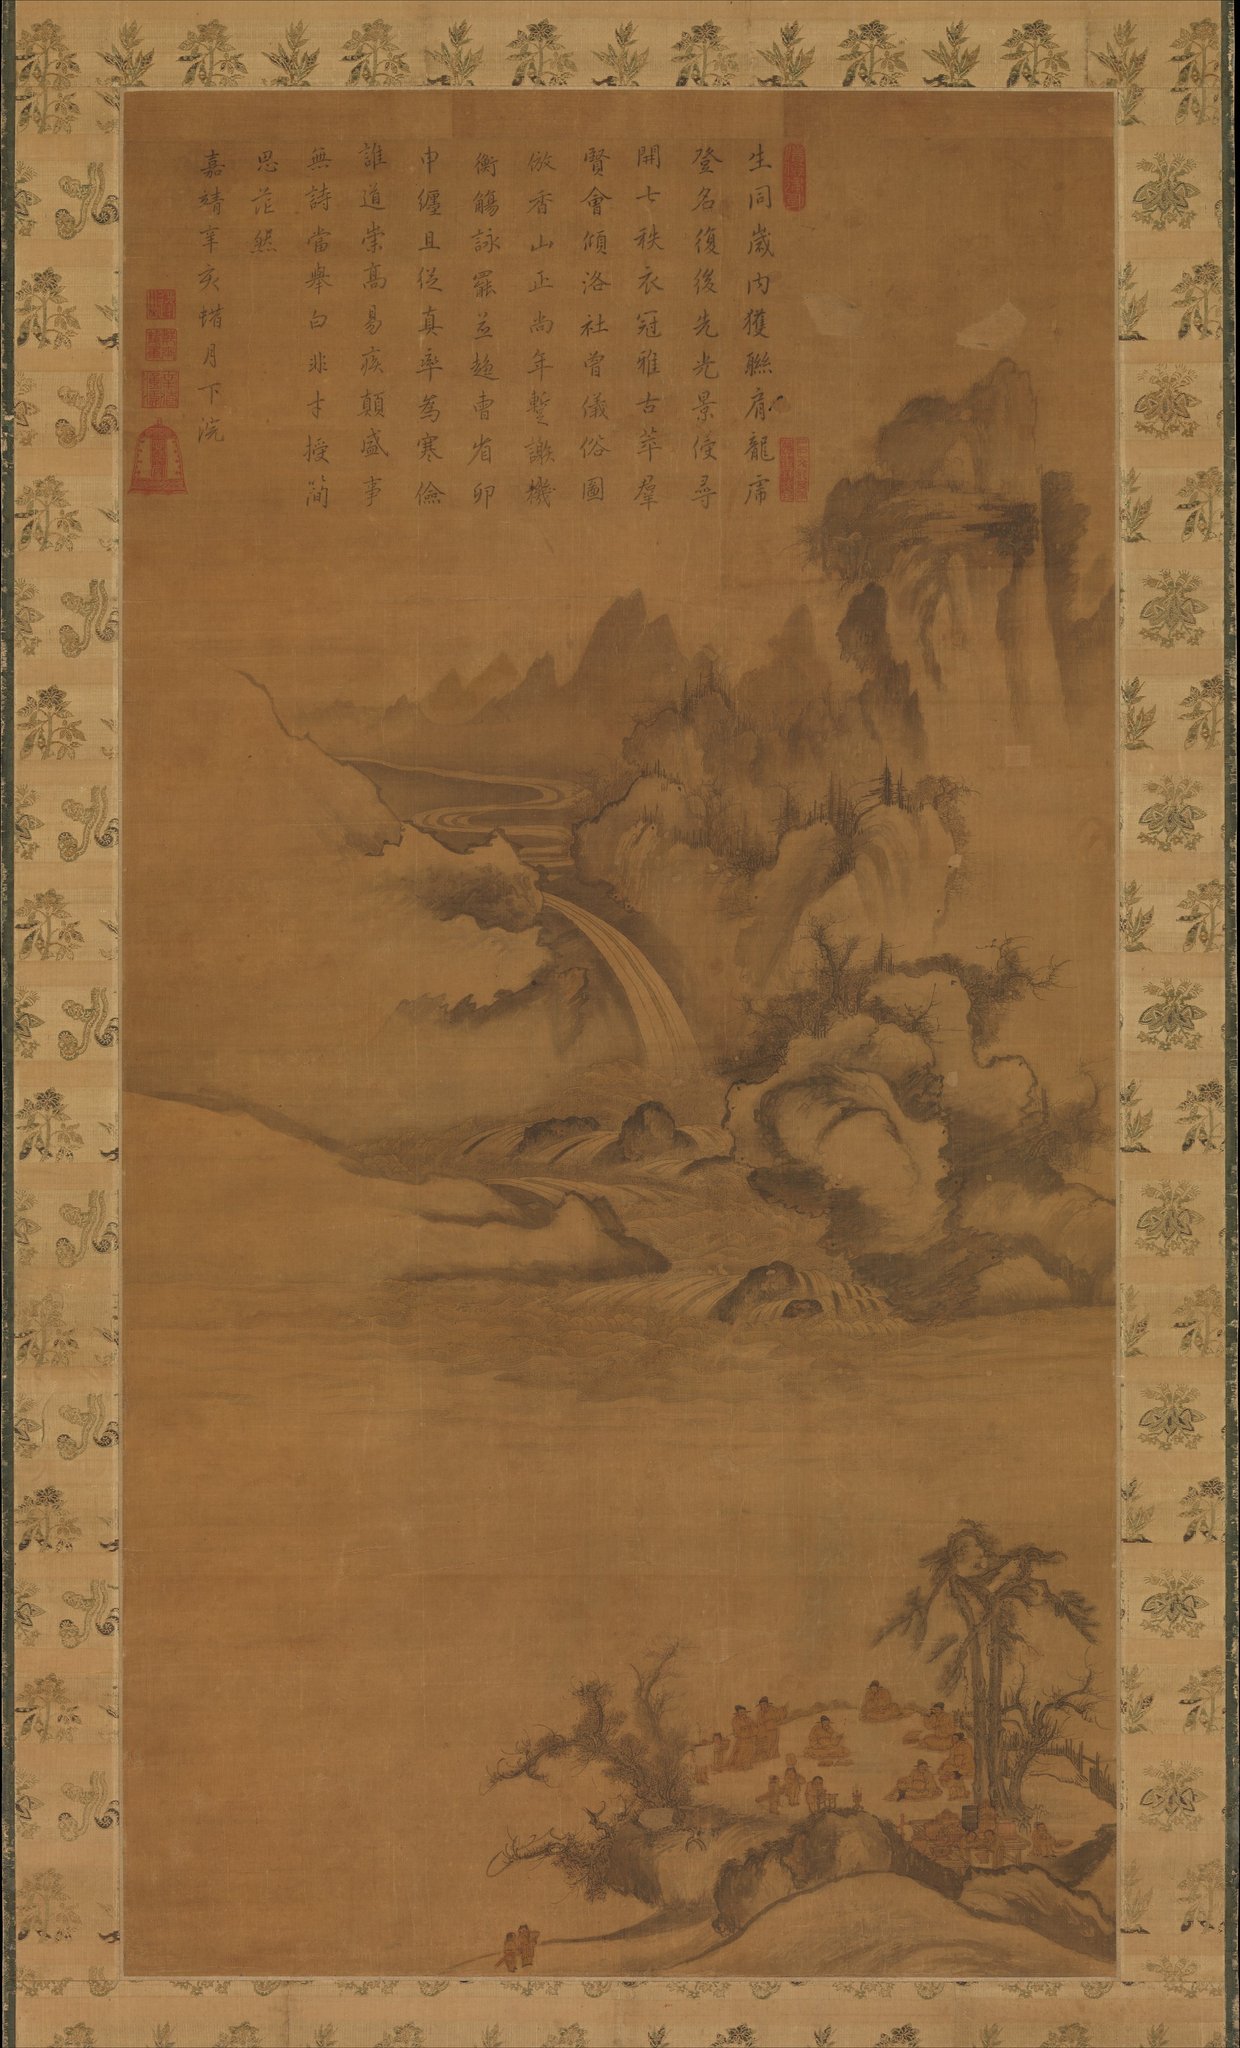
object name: hanging scroll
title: Gathering of government officials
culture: korean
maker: unidentified artist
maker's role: artist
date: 1551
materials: ink, silk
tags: waterfalls,mountains,landscapes